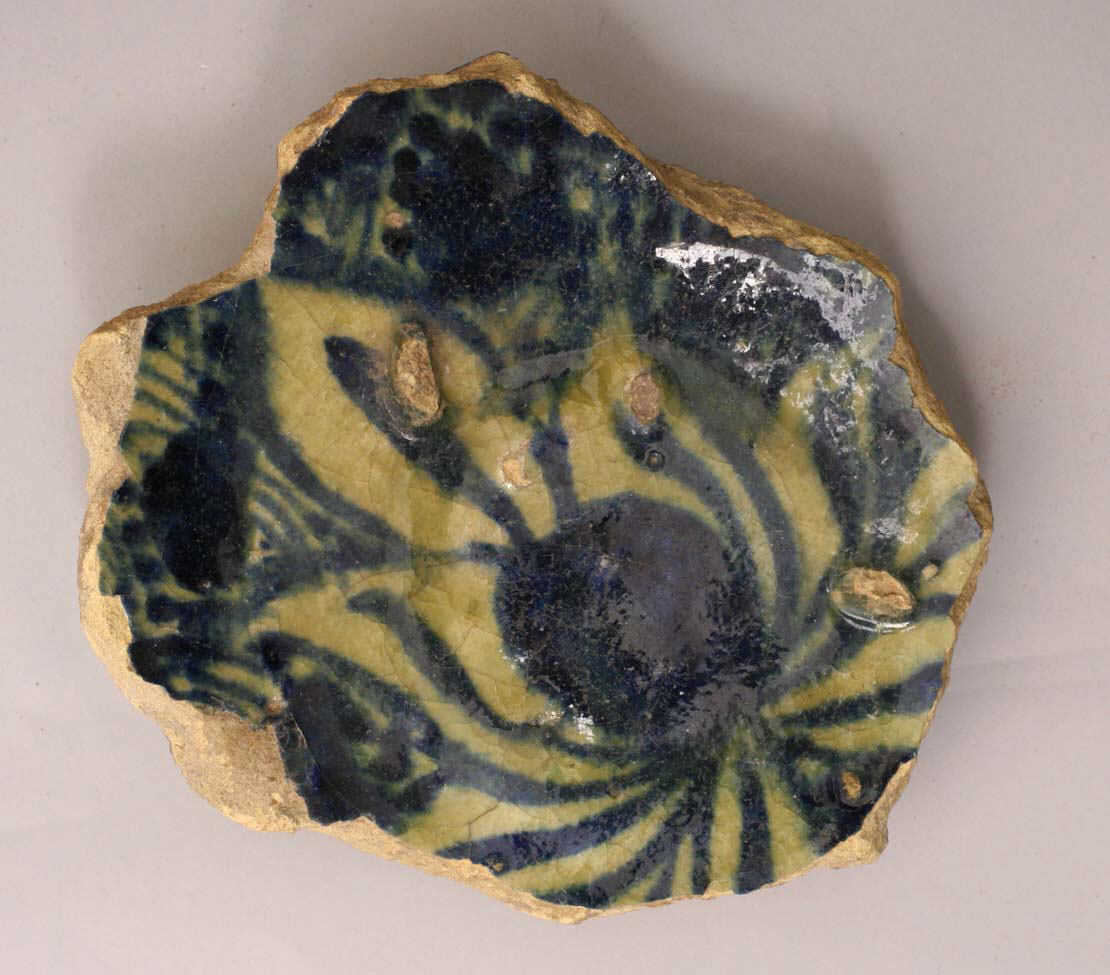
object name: fragment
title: Fragment of a Bowl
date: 1401-1500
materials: stonepaste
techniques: painting, underglaze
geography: egypt